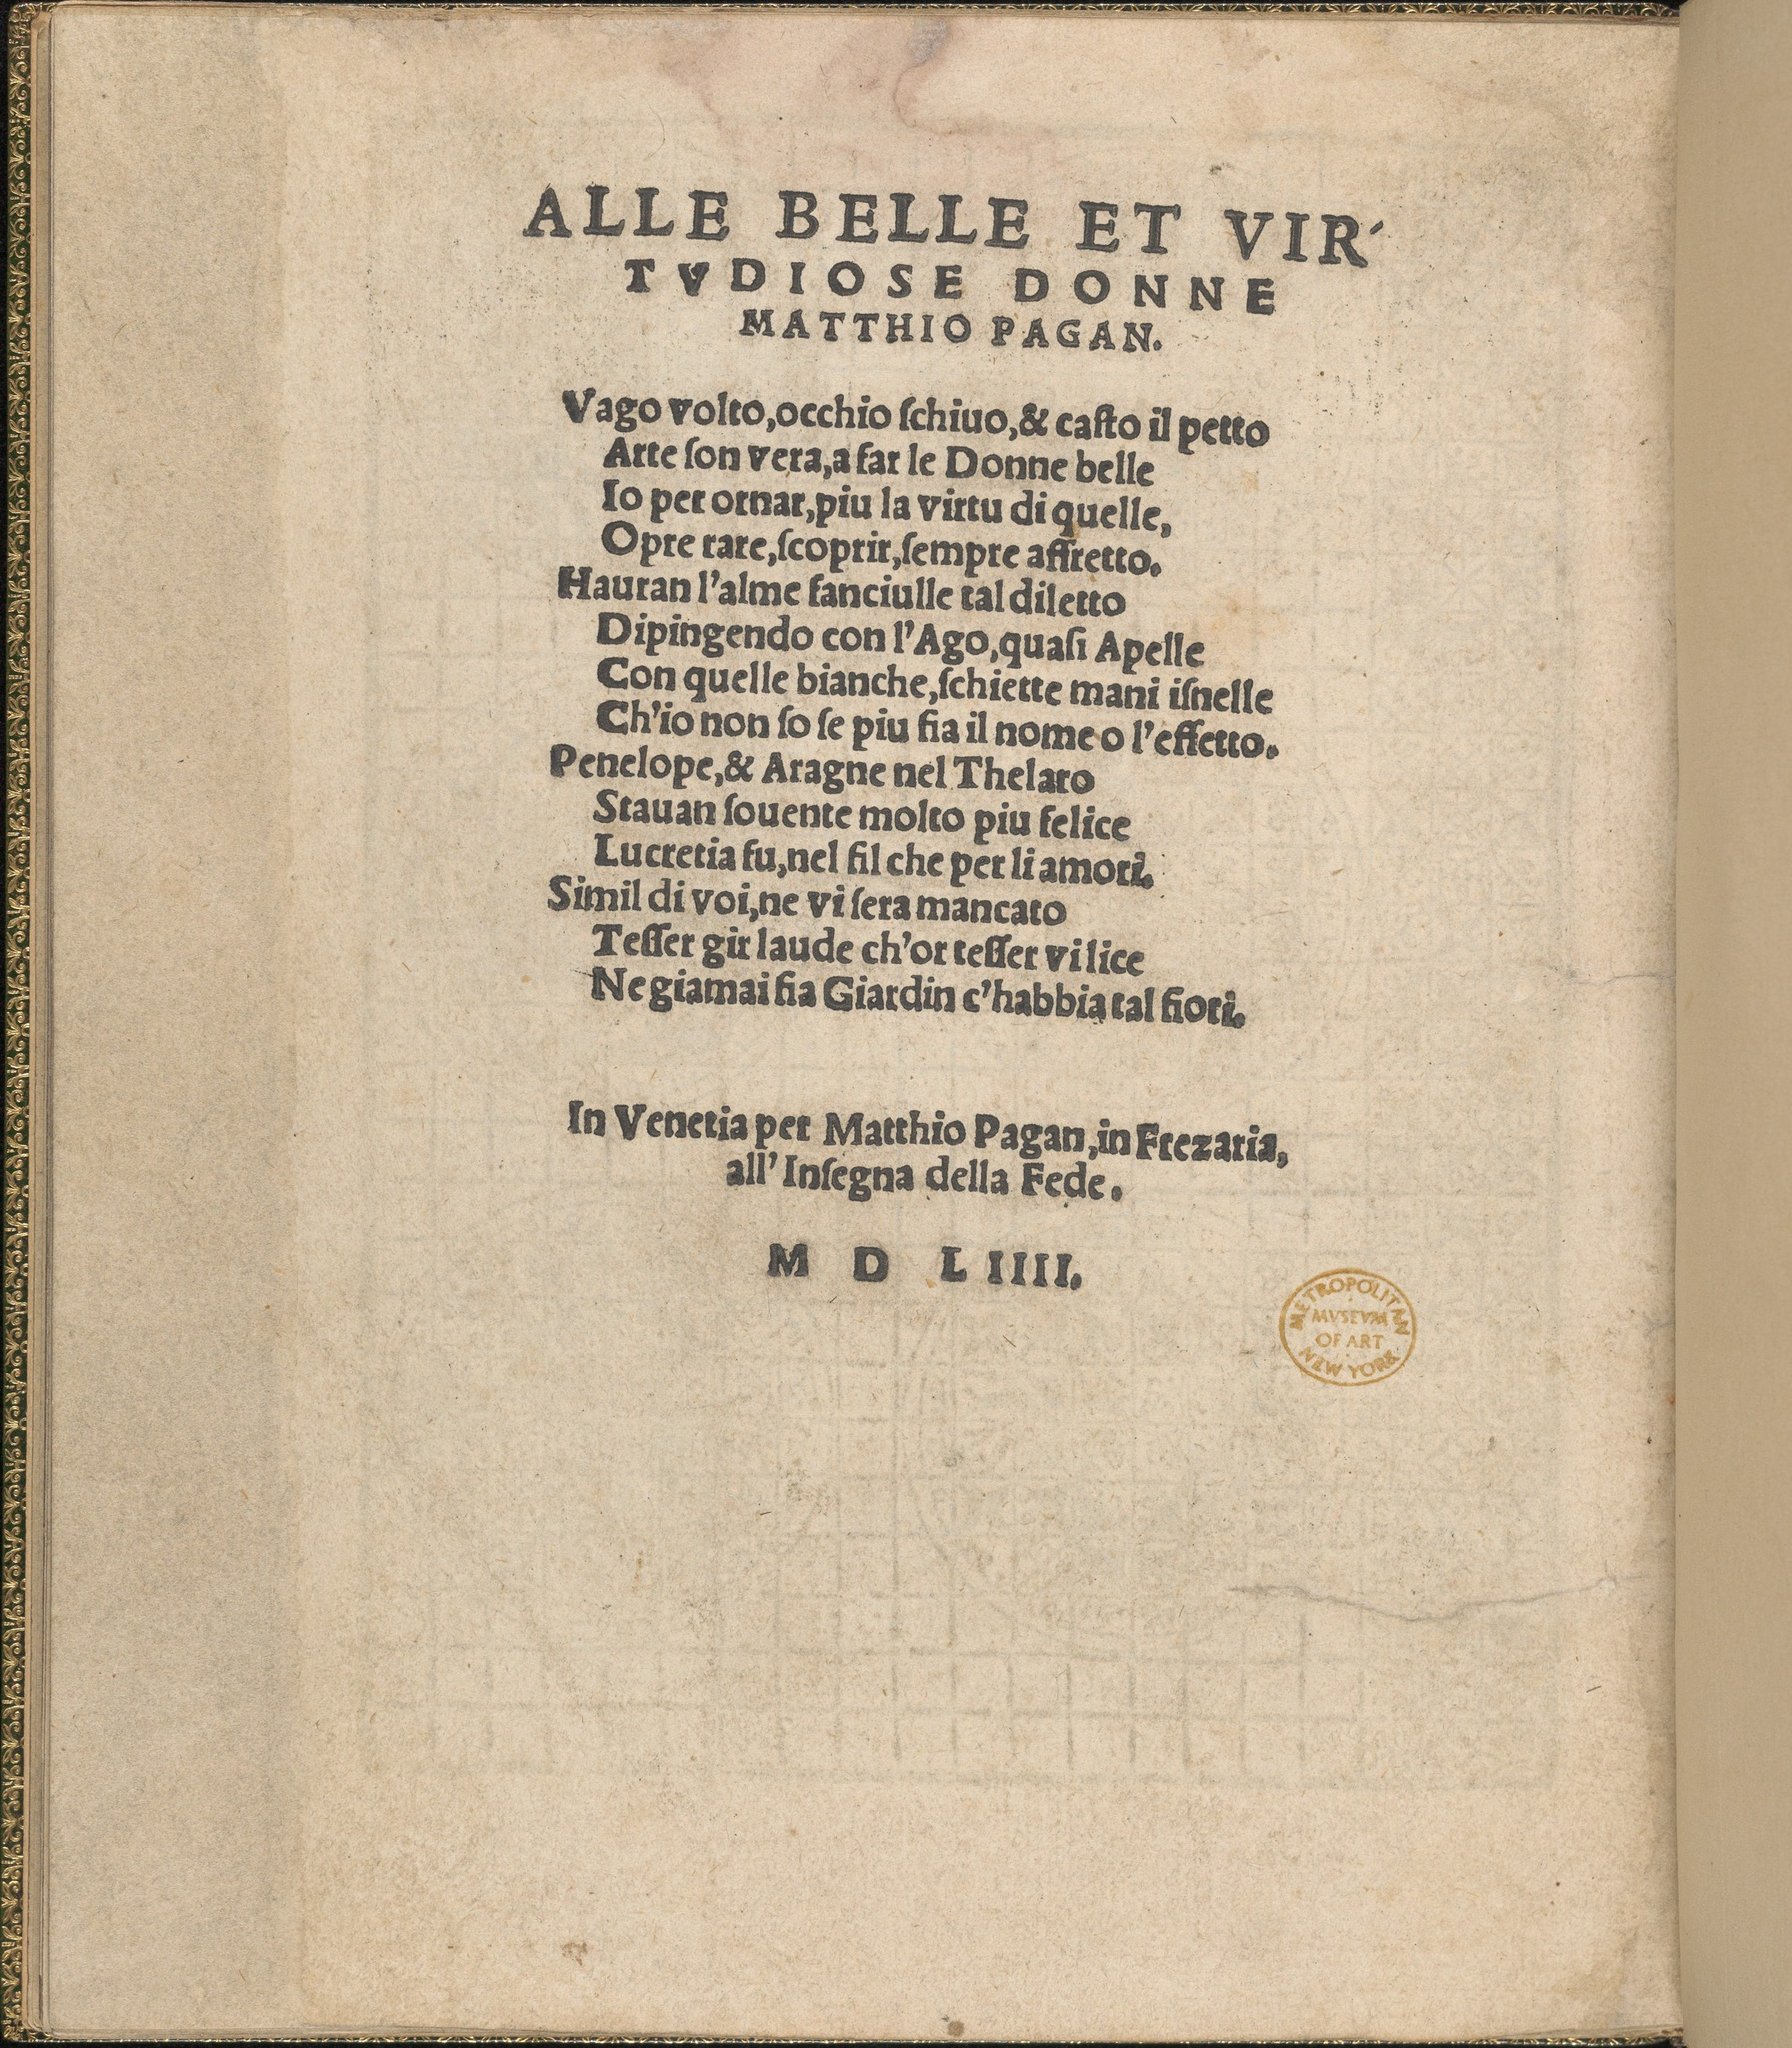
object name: book print ornament architecture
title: Giardineto novo di punti tagliati et gropposi per exercitio & ornamento delle donne (Venice 1554), page 24 (verso)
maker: matteo pagano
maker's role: publisher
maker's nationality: italian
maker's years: 1515-1588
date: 1554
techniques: woodcut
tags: poetry